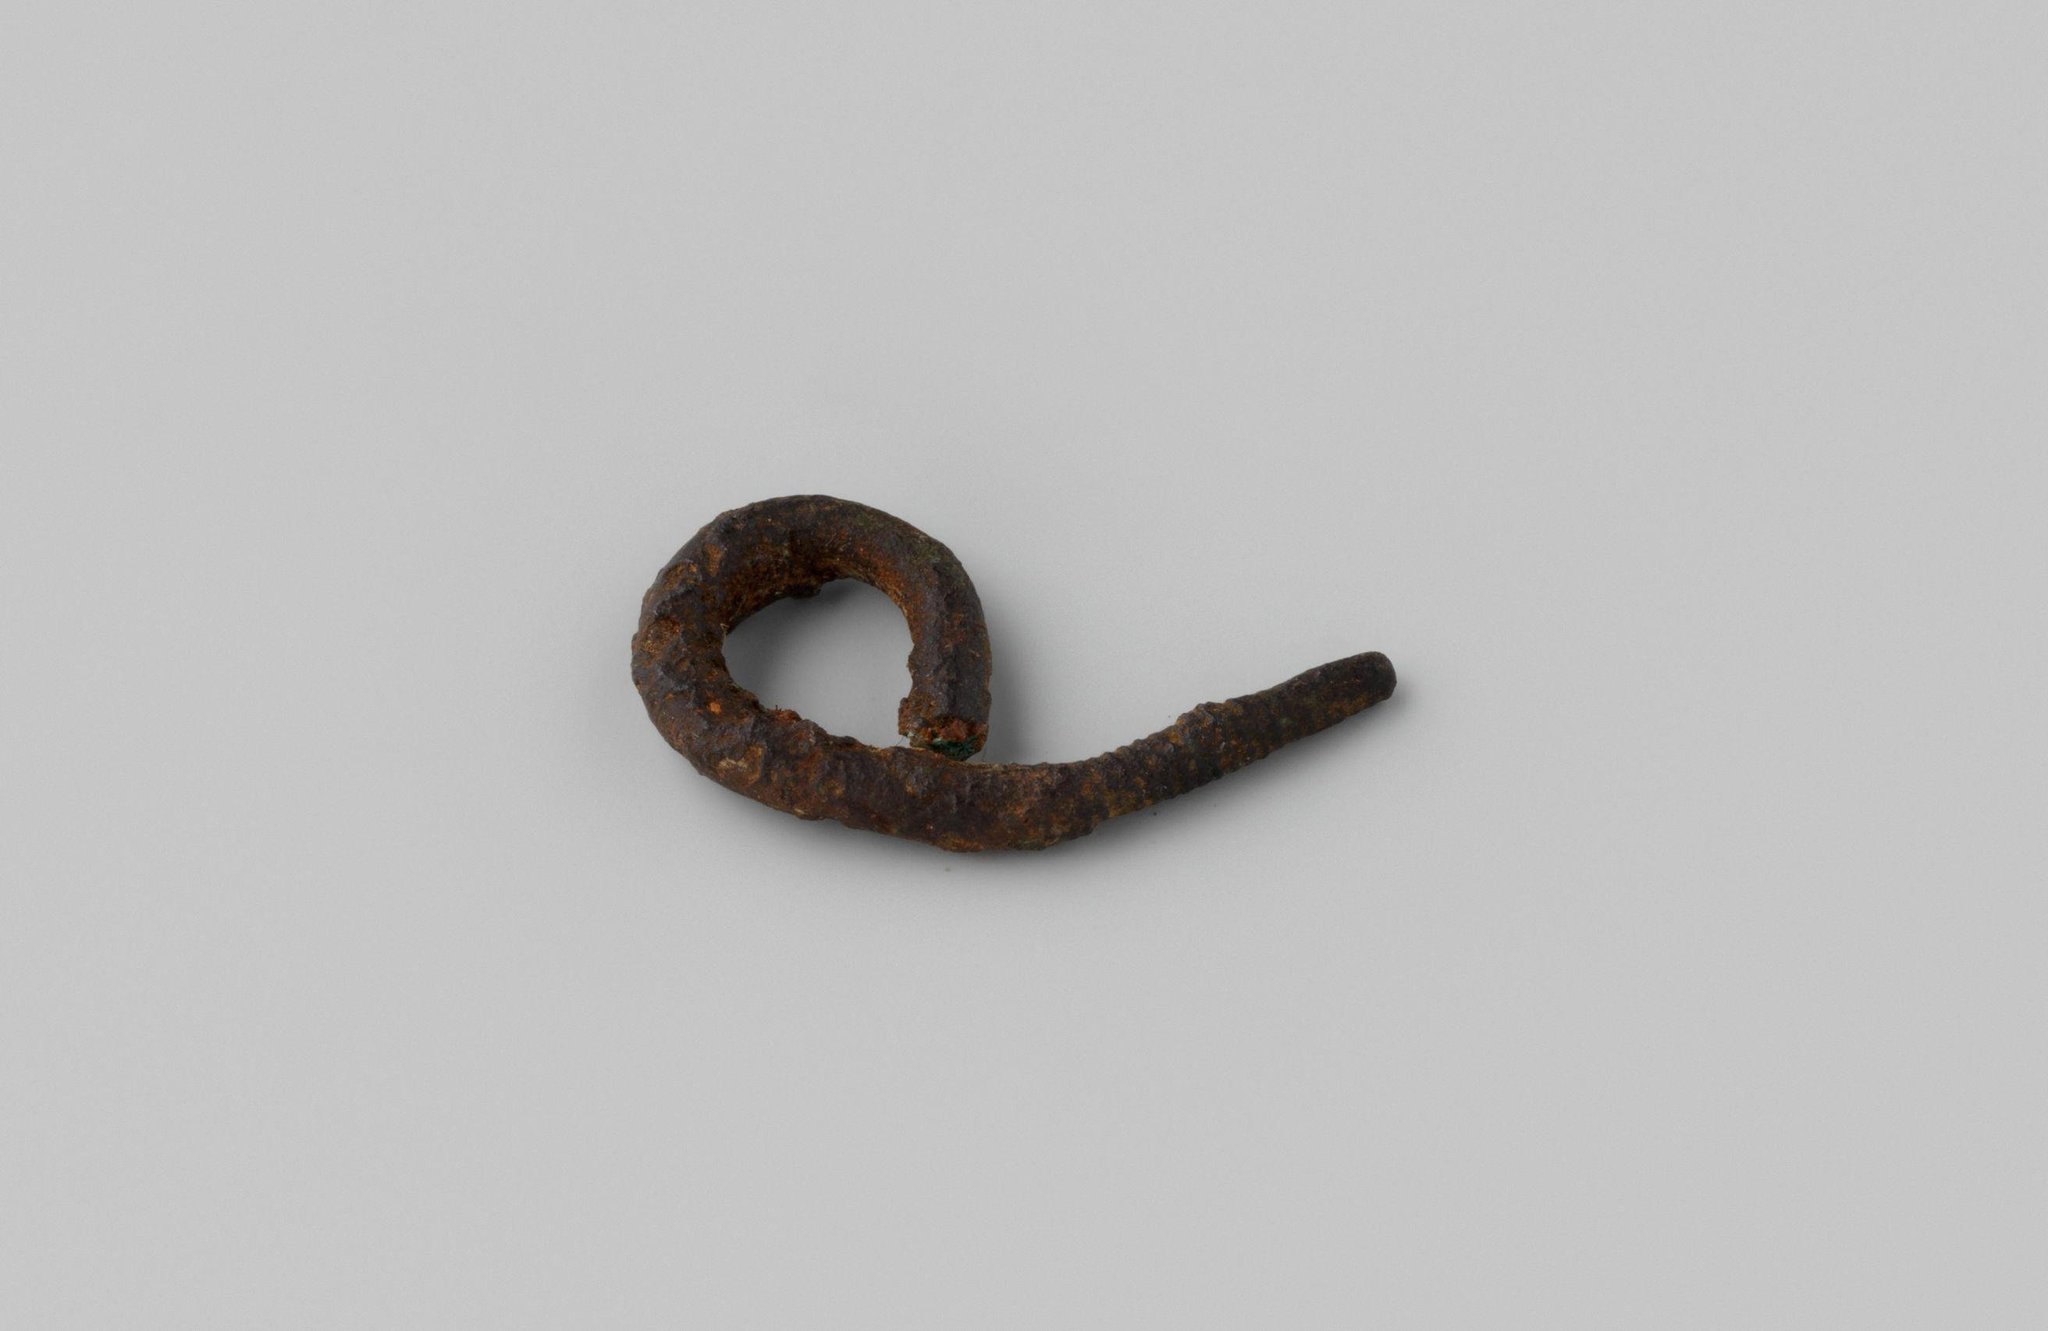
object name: screw eye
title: Schroefoog afkomstig uit het wrak van de Oost-Indiëvaarder Hollandia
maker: Anonymous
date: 1700-1743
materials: iron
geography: netherlands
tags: verenigde oostindische compagnie, hollandia (schip)